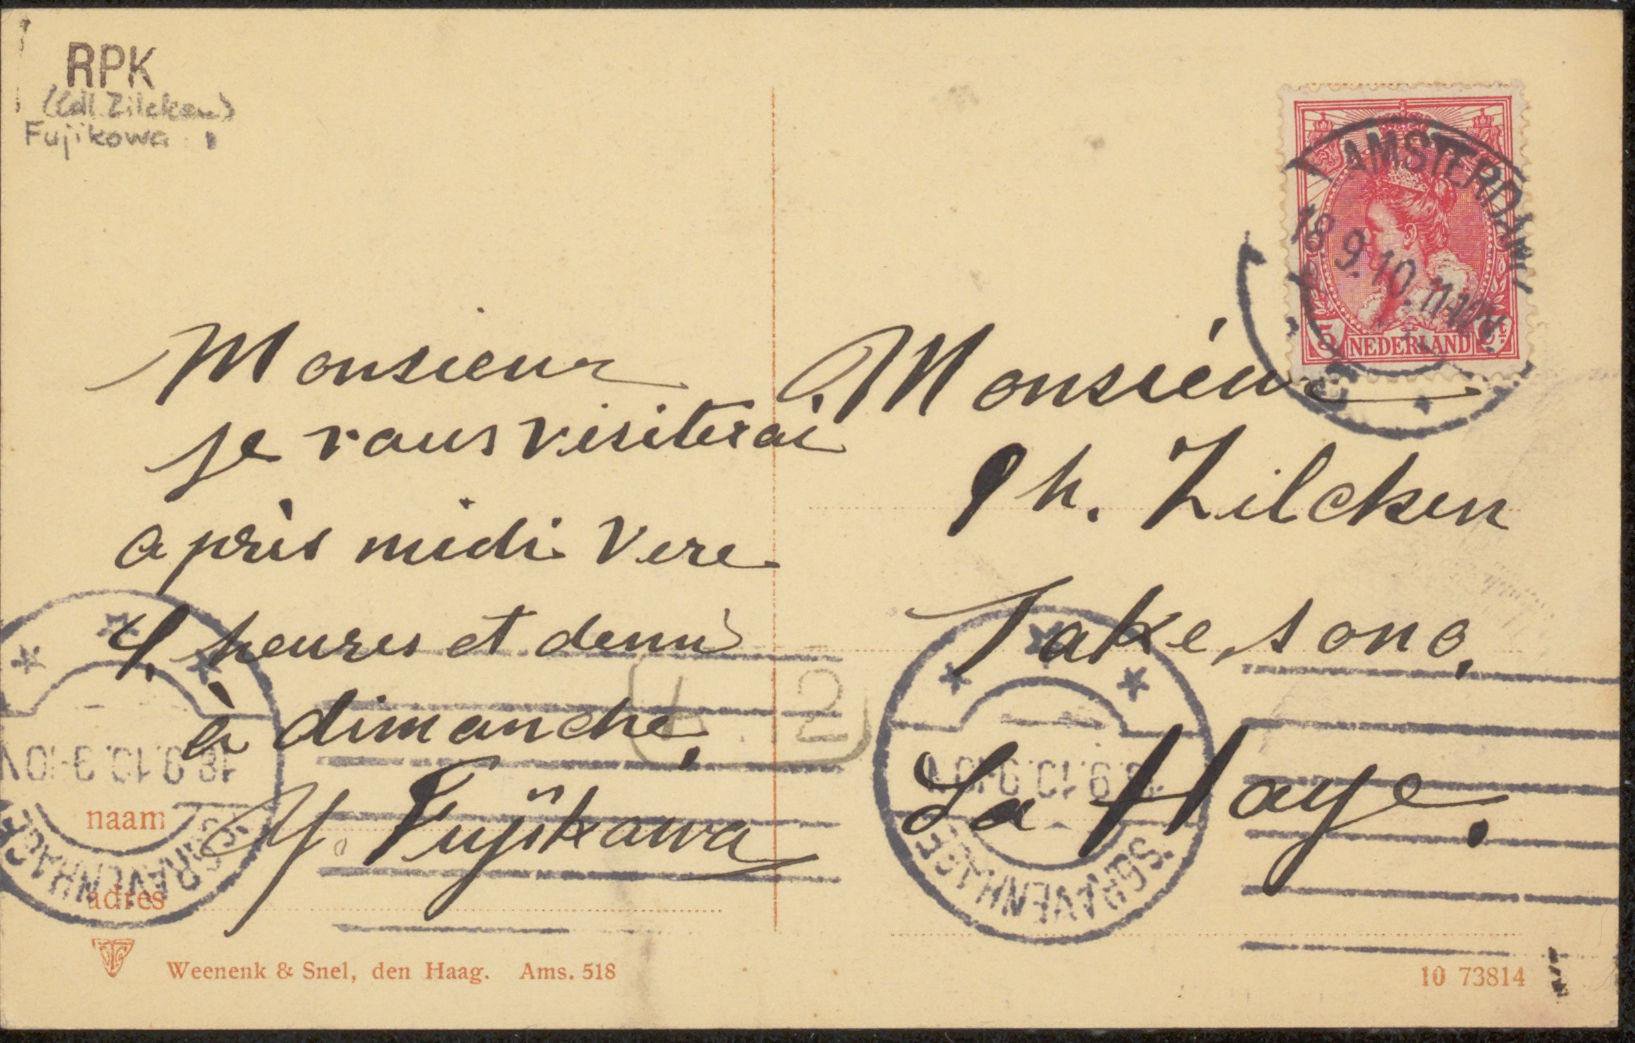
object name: ansichtkaart, prentbriefkaart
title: Prentbriefkaart aan Philip Zilcken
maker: j. fujikawa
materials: cardboard, ink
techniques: photograph, pen, writing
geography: amsterdam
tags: the hague, painter, draughtsman, philip zilcken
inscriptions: collector's mark: ‘RPK’